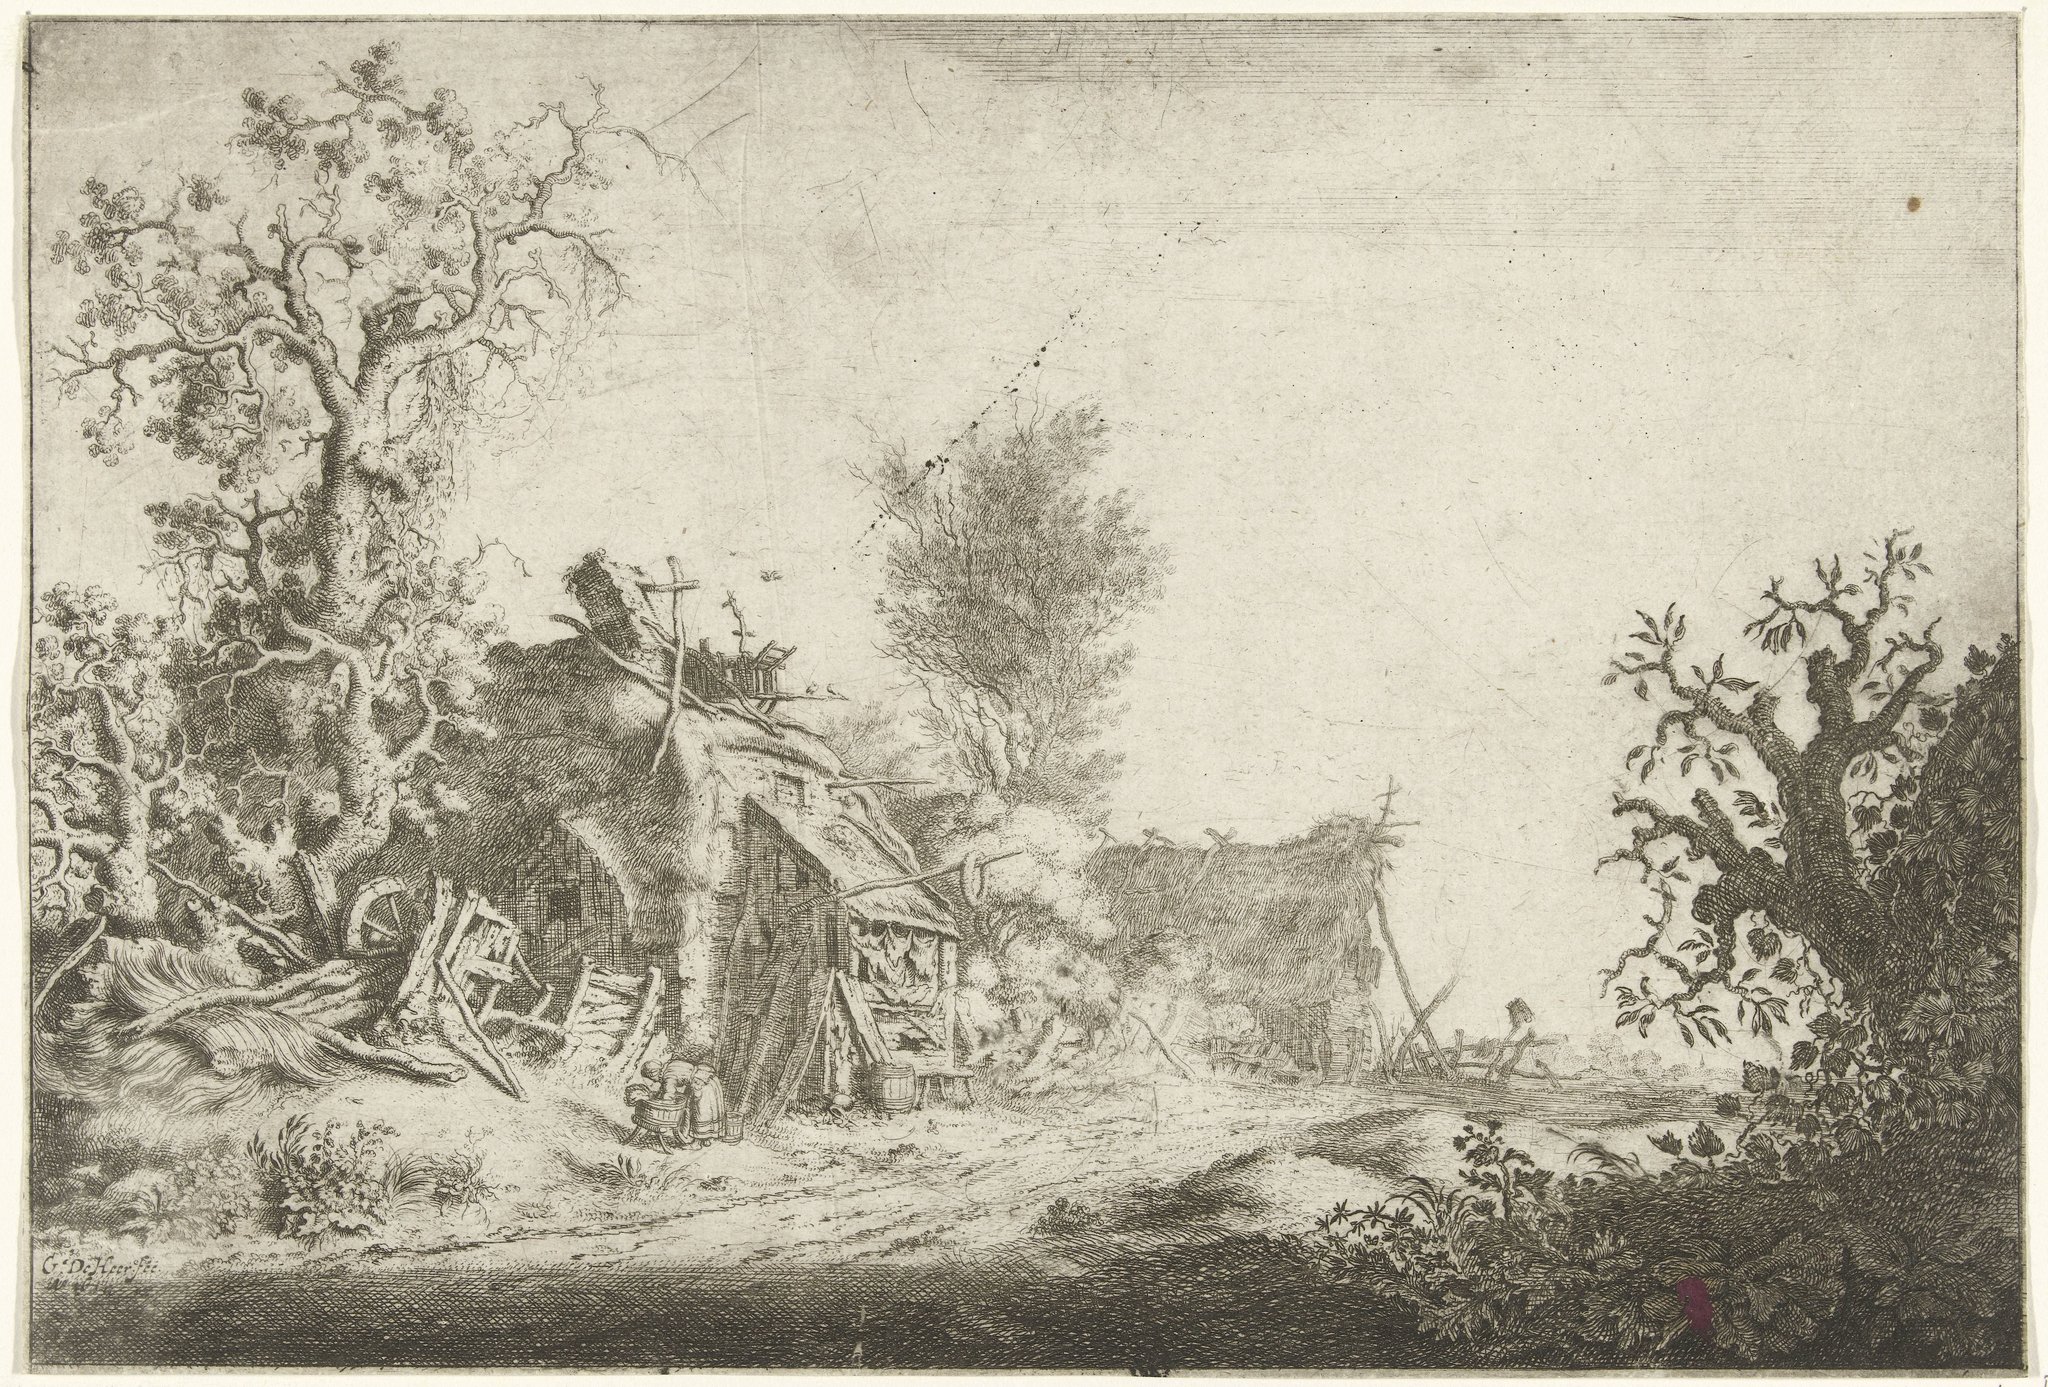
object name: print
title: Landschap met vervallen boerderijen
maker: gerrit adriaensz. de heer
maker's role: draughtsman, painter, print maker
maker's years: 1606-1670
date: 1634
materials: paper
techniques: etching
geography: northern netherlands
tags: laundering, farm or solitary house in landscape (+ city(-scape) with figures, staffage)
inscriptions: collector's mark: Lugt 240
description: Een vrouw bij een wastobbe in een landschap met twee vervallen boeren woningen.